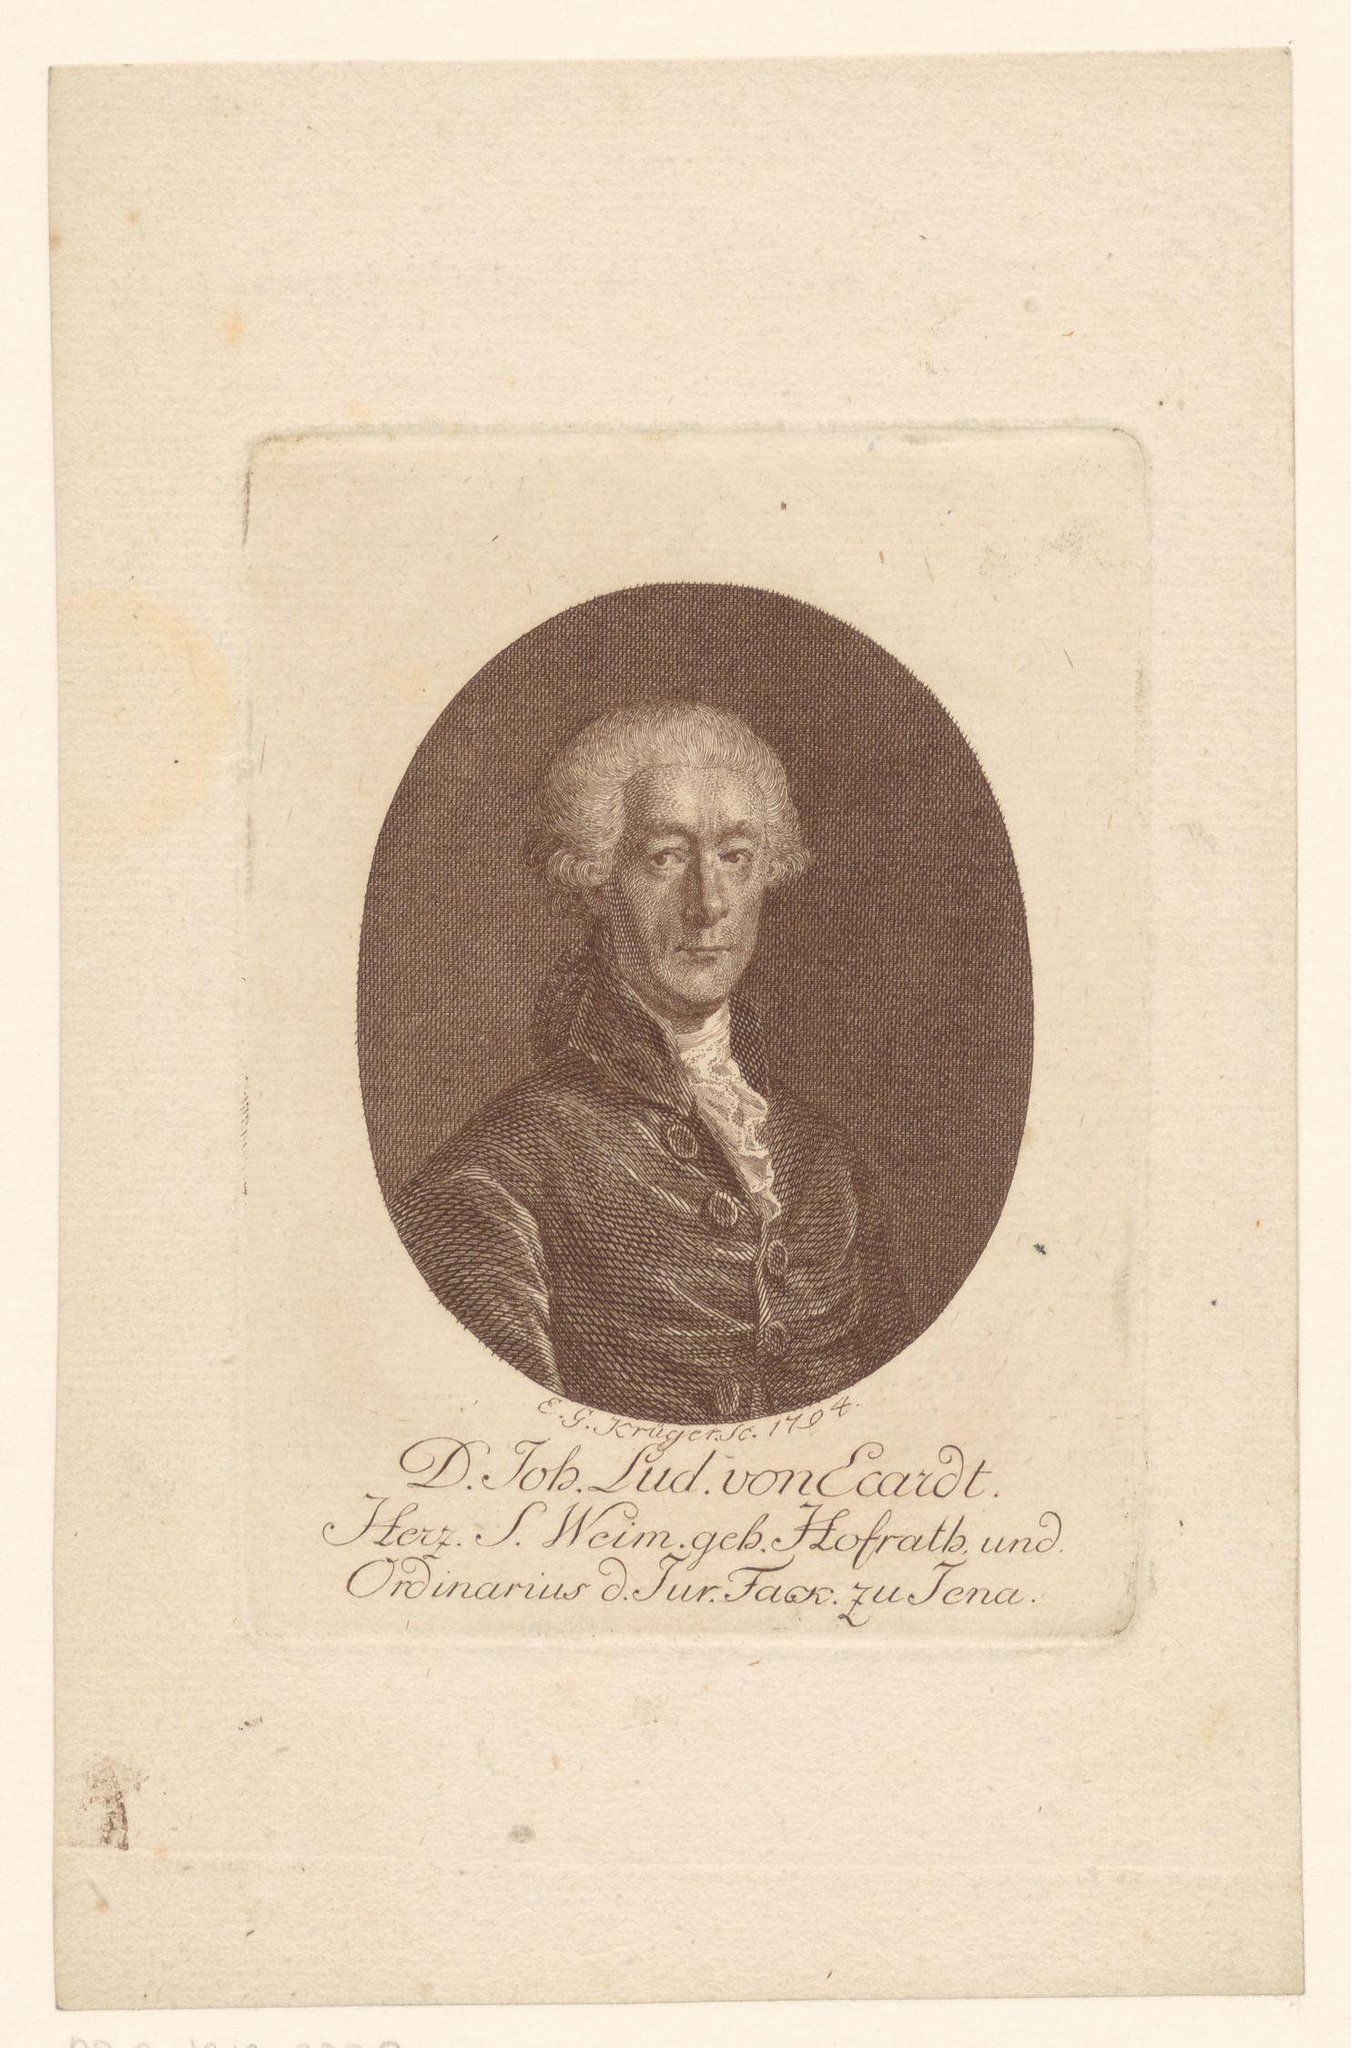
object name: print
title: Portret van Johann Ludwig von Eckardt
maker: ephraïm gottlieb krüger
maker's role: print maker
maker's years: 1756-1834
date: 1794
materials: paper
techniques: engraving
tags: further education (+ portrait of teacher, professor), historical persons, lawyer, attorney at law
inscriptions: collector's mark: Lugt 2228